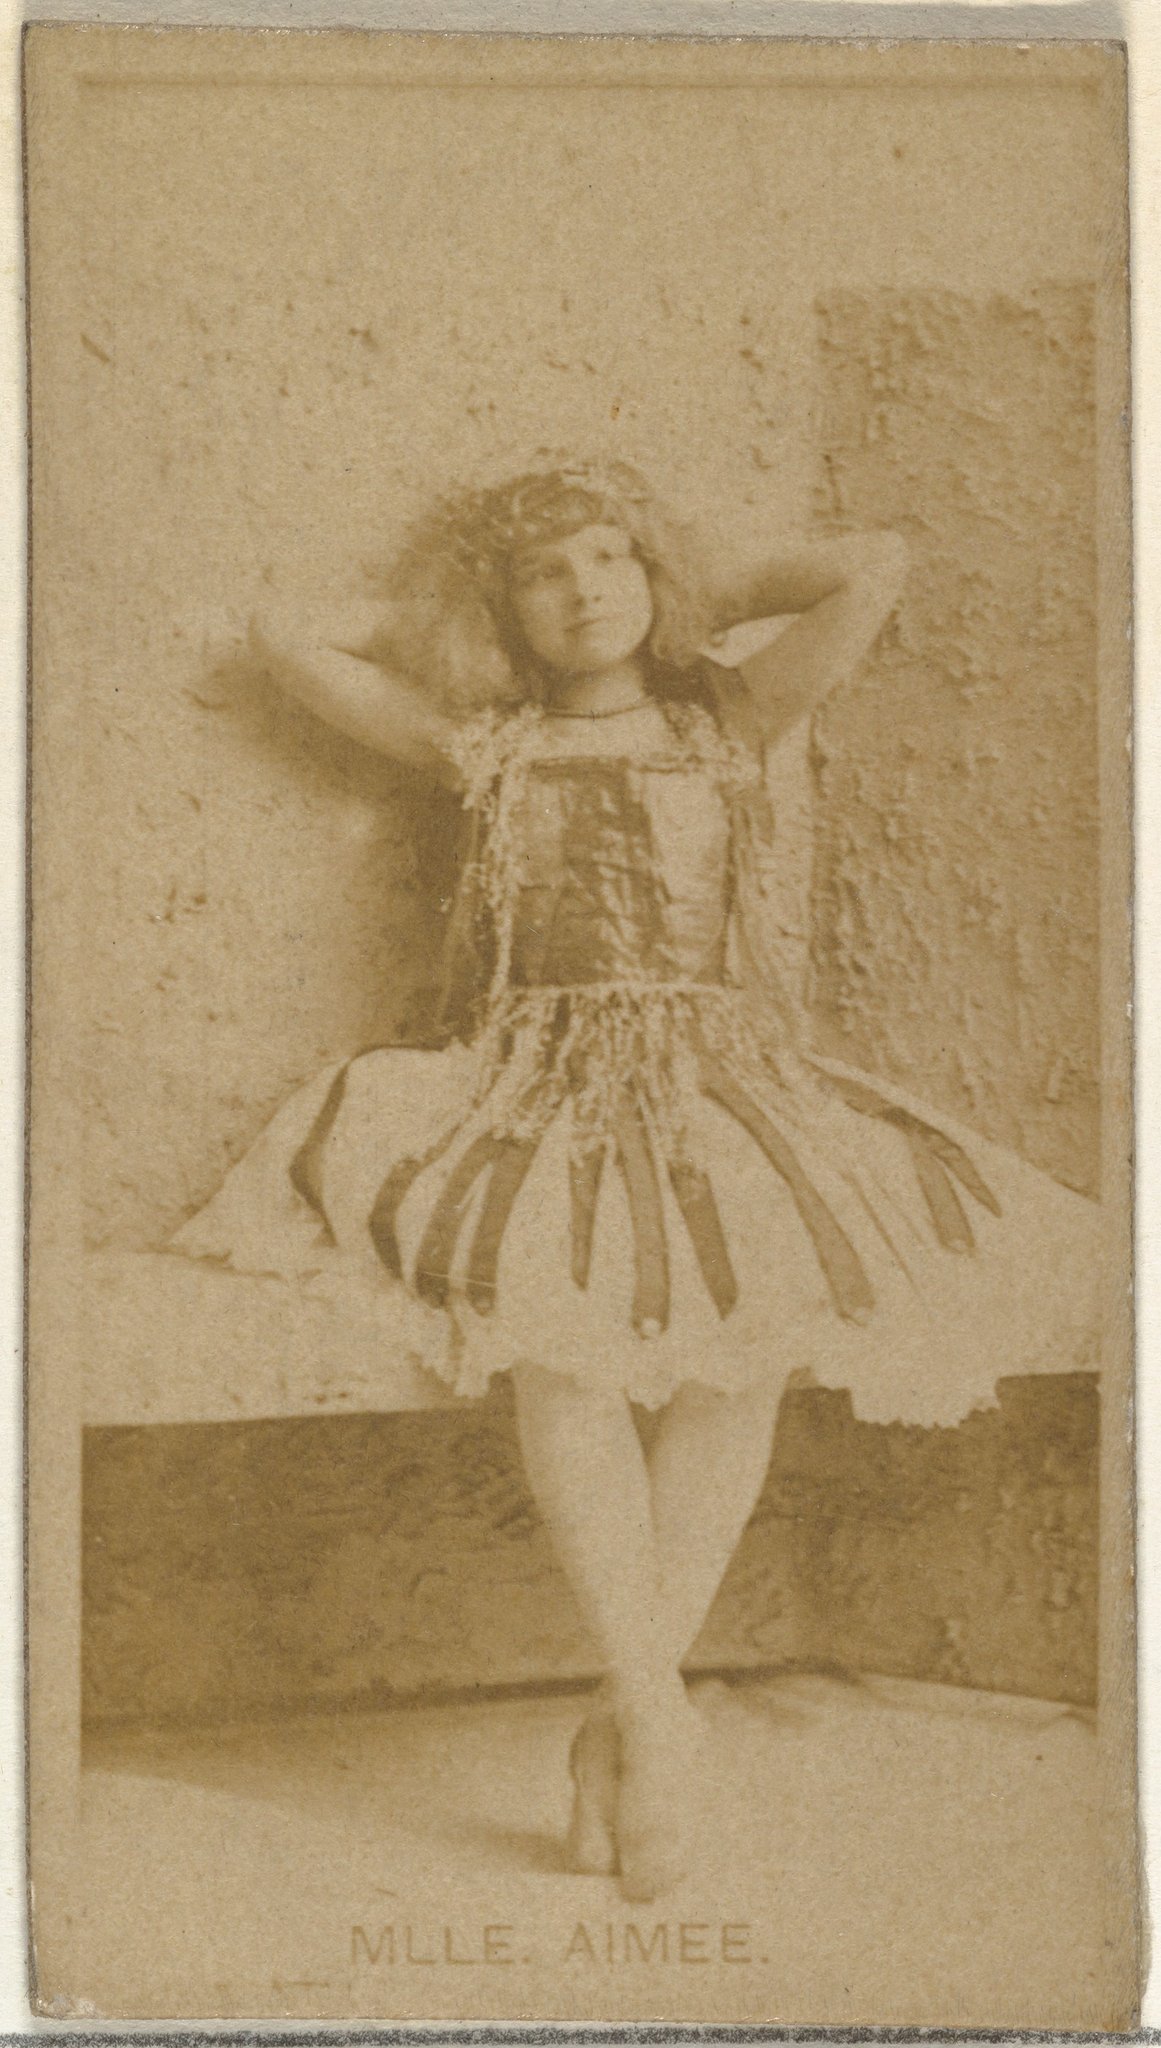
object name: photograph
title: Mlle. Aimee, from the Actors and Actresses series (N145-8) issued by Duke Sons & Co. to promote Duke Cigarettes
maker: w. duke, sons & co.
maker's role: publisher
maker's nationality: american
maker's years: 1870-1920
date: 1891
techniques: albumen silver print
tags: portraits,women,actresses